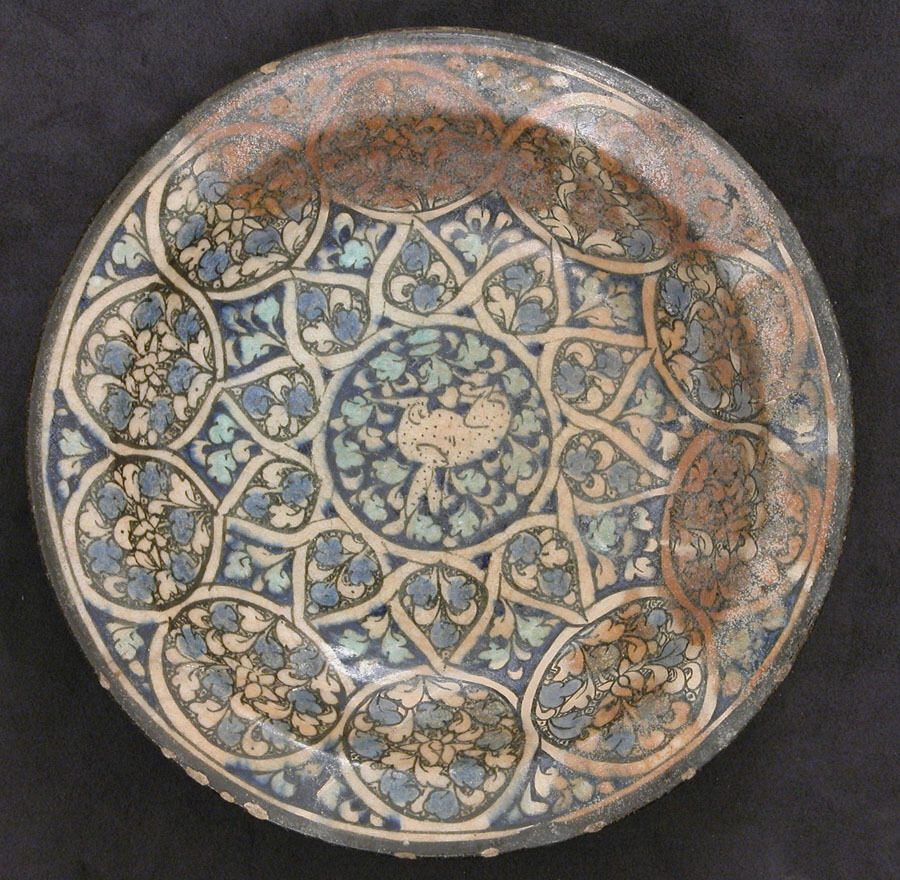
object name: dish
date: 1301-1400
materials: glaze, stonepaste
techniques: painting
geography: iran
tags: rabbits